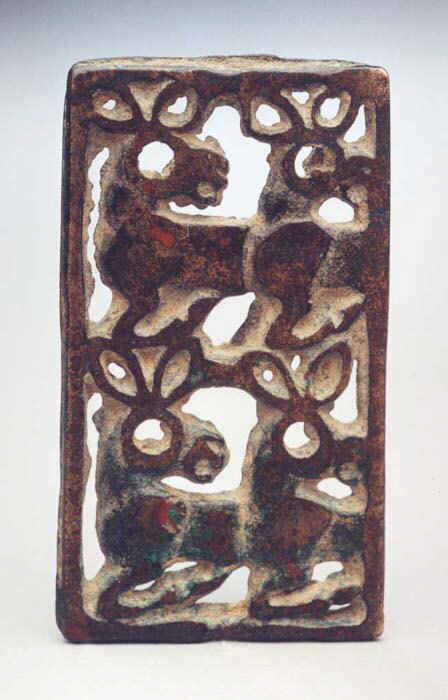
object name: garment plaque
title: Garment Plaque with a Kulan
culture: north chinese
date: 600-401 BCE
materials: bronze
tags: animals